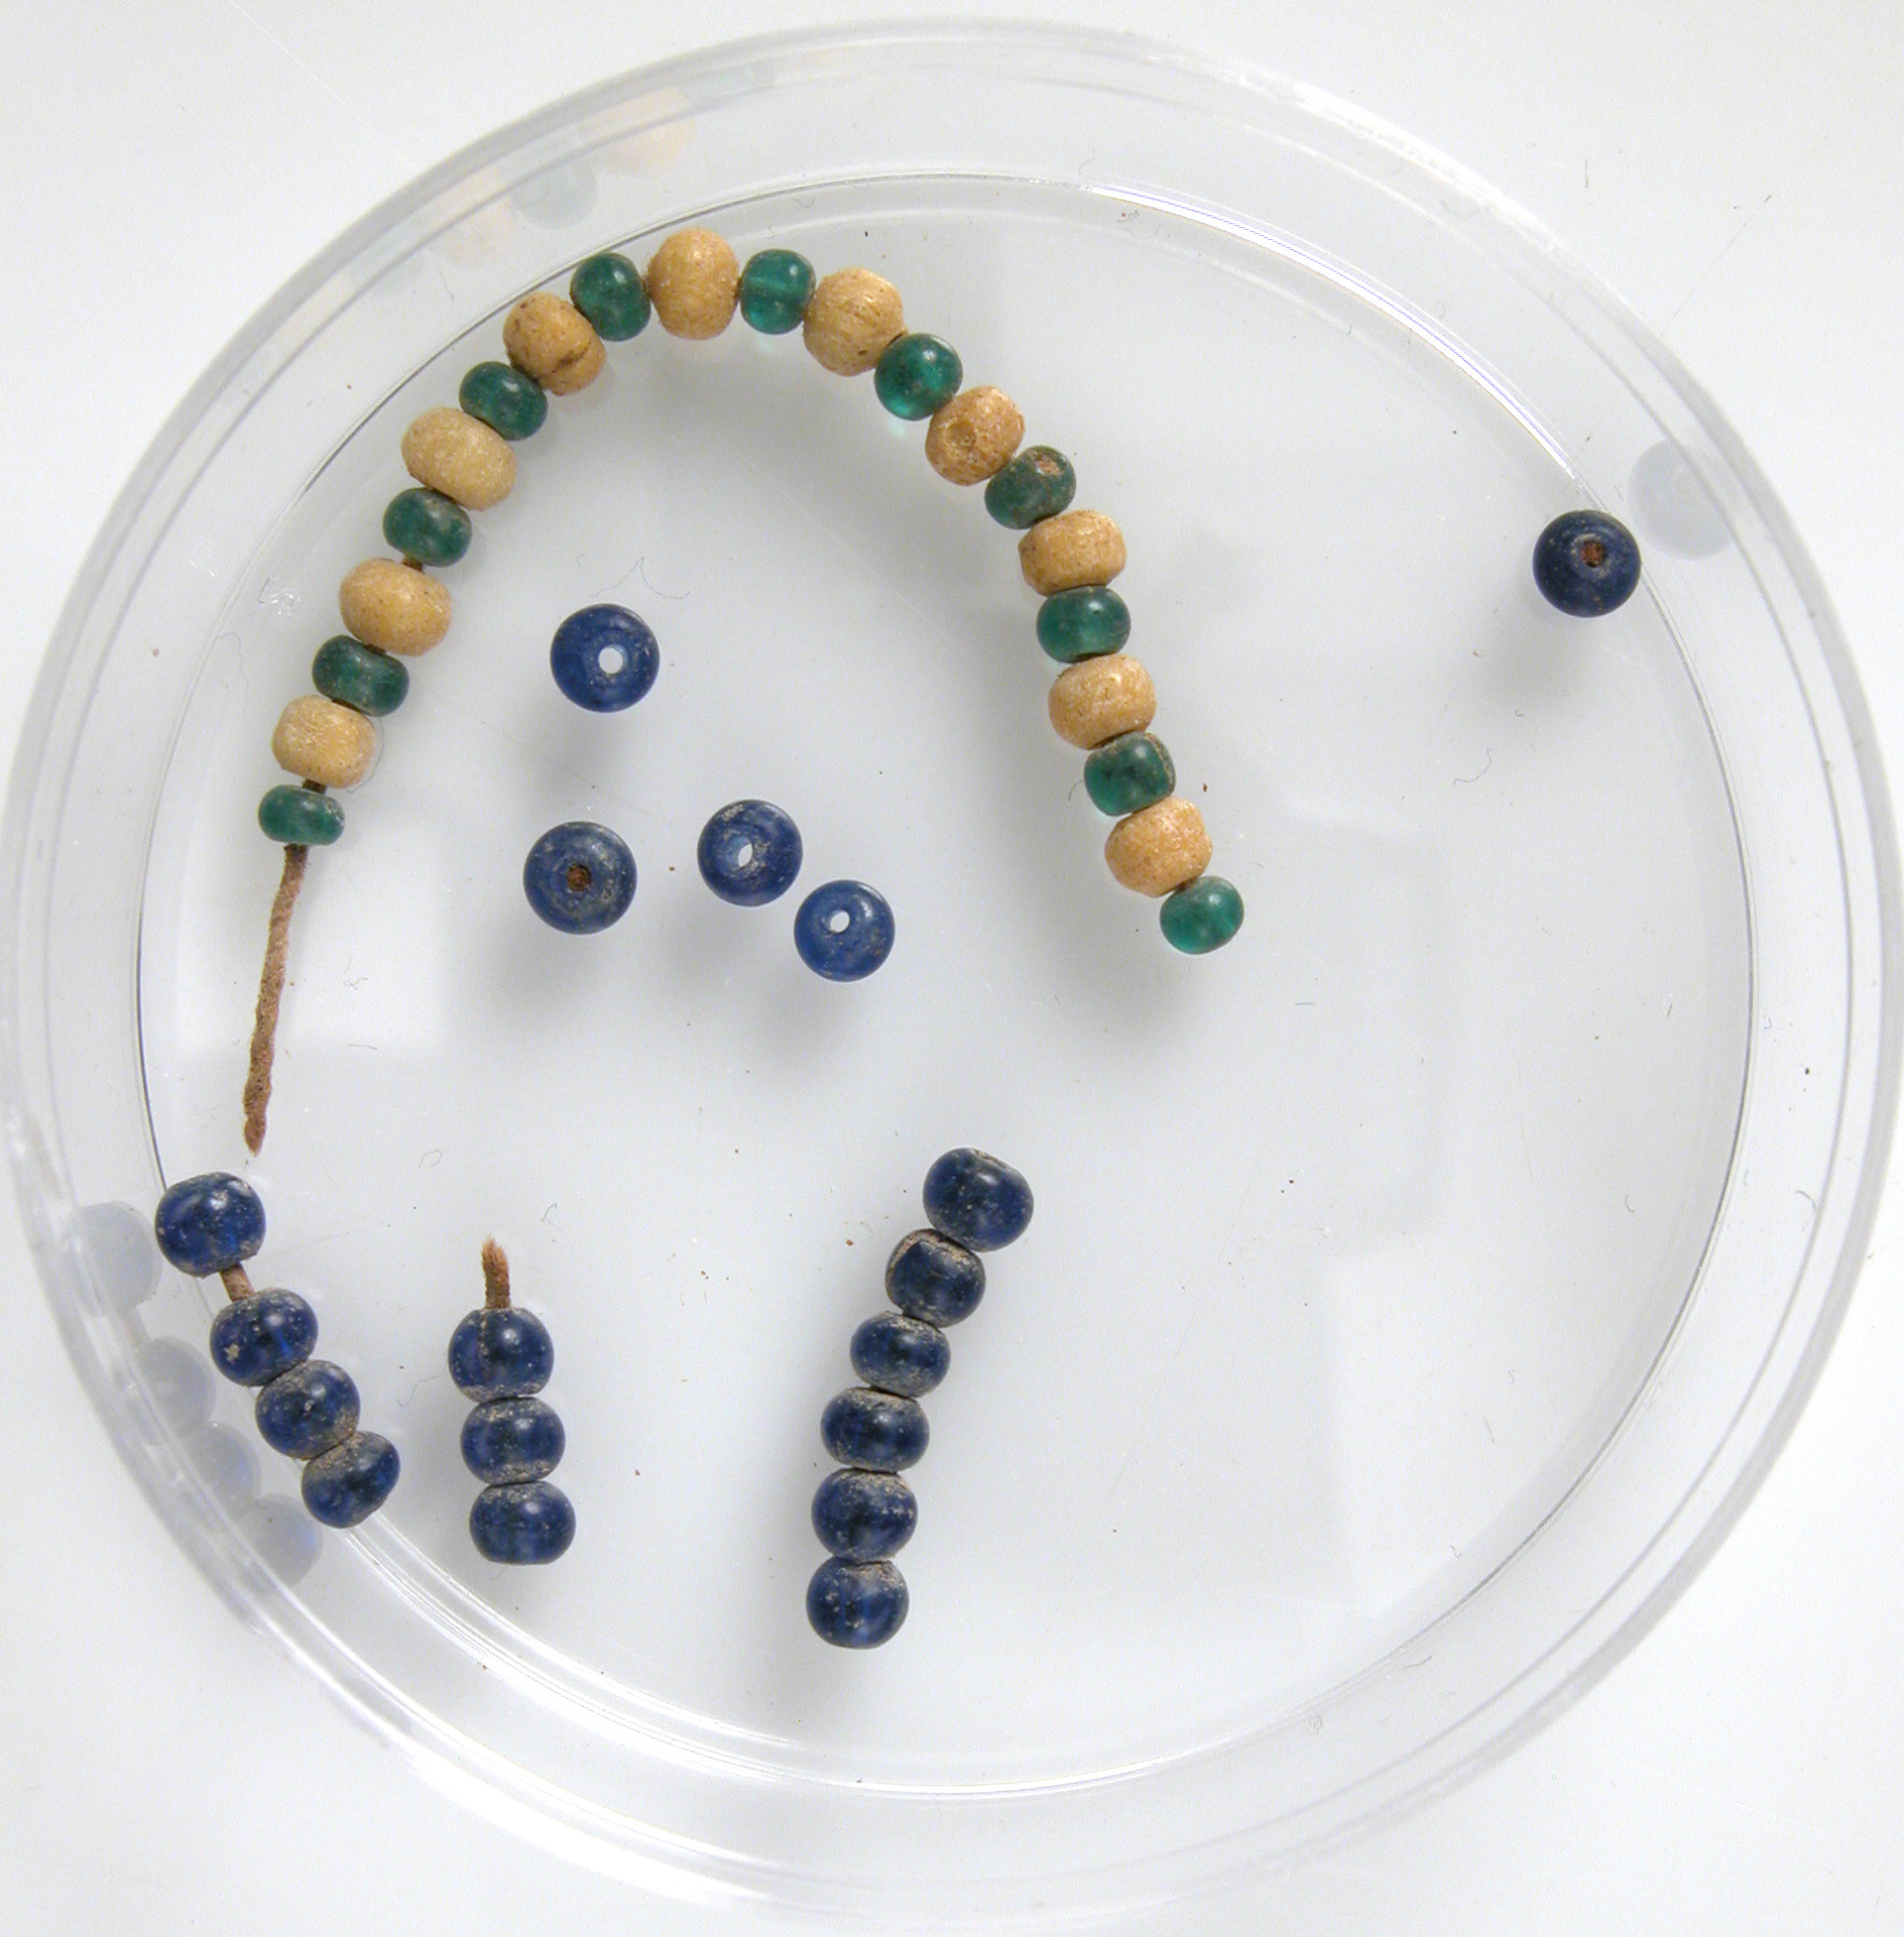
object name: bead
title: Beads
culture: coptic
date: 301-700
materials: glass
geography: egypt